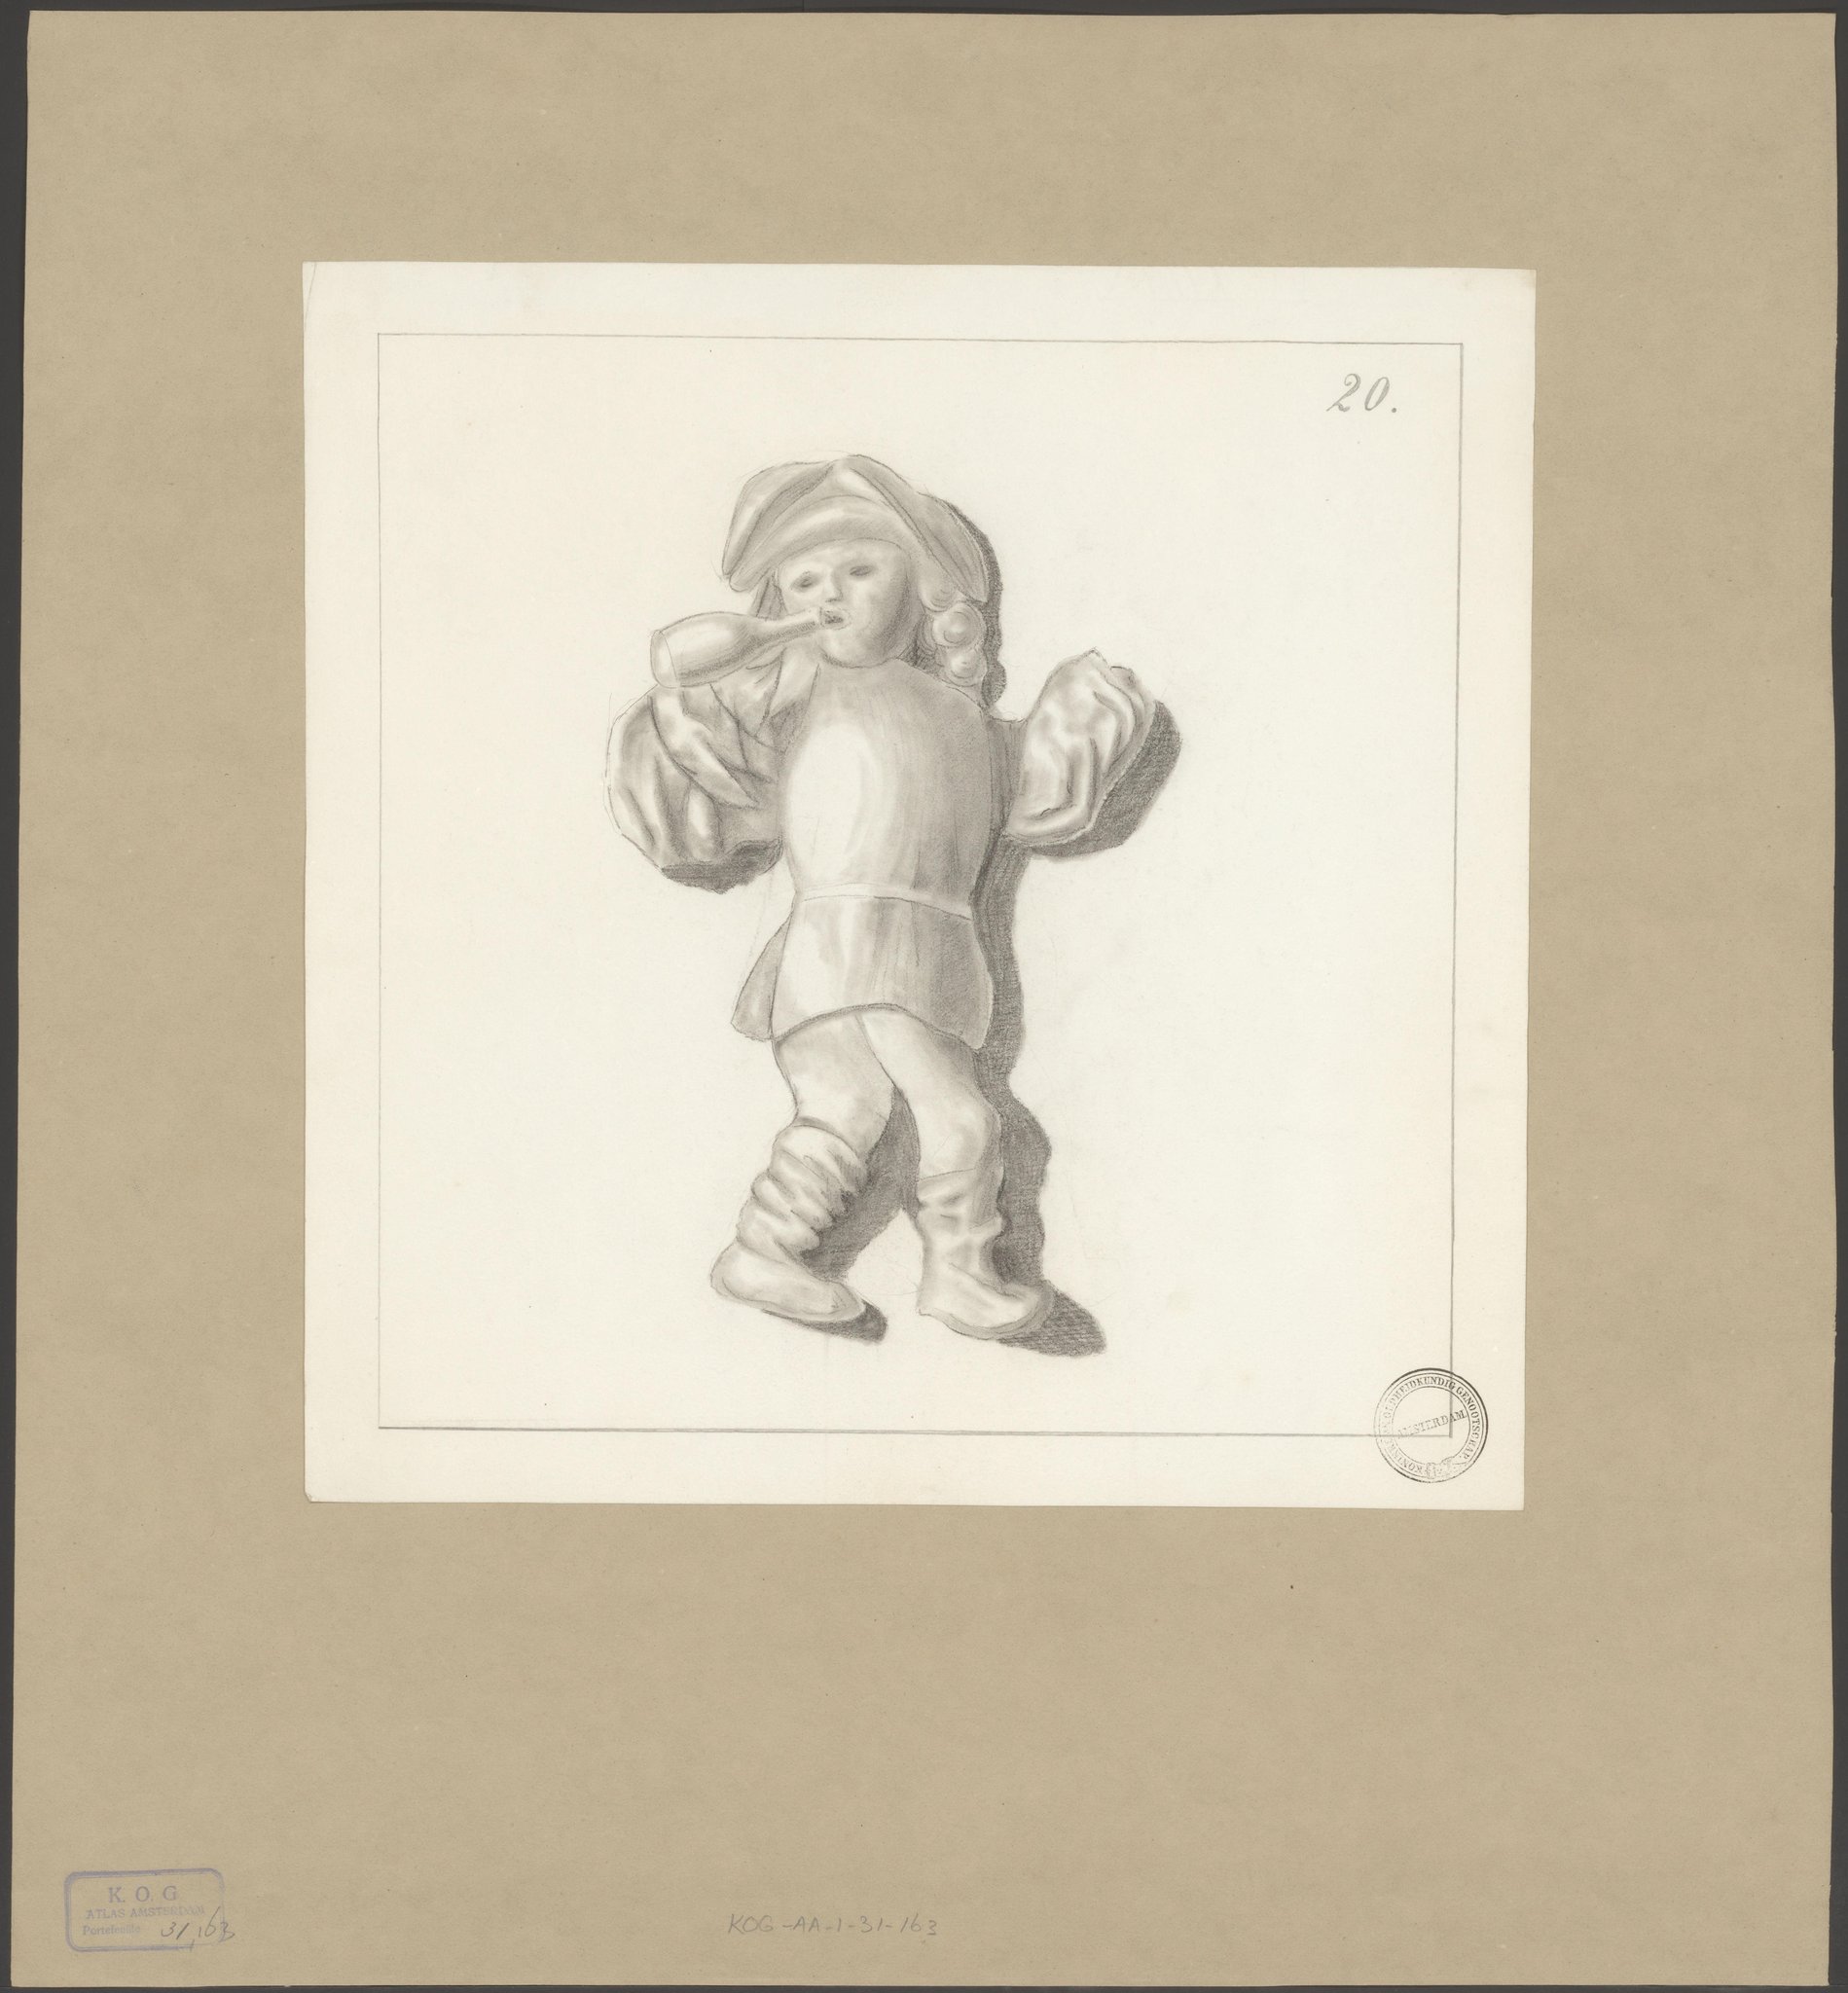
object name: print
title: Misericorde met drinkende man in de Oude Kerk te Amsterdam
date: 1880-1929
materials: paper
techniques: lithograph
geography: amsterdam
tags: misericords, drinking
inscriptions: collector's mark: ‘31,163’ Lugt 1641b, collector's mark: ‘Koninklijk Oudheidkundig Genootschap / Amsterdam’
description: Rechtsboven genummerd: 20. Onderwerpsrubriek binnen de Atlas Amsterdam: Kerkwezen: Hervormde Gemeente: Oude Kerk, koorgestoelte.